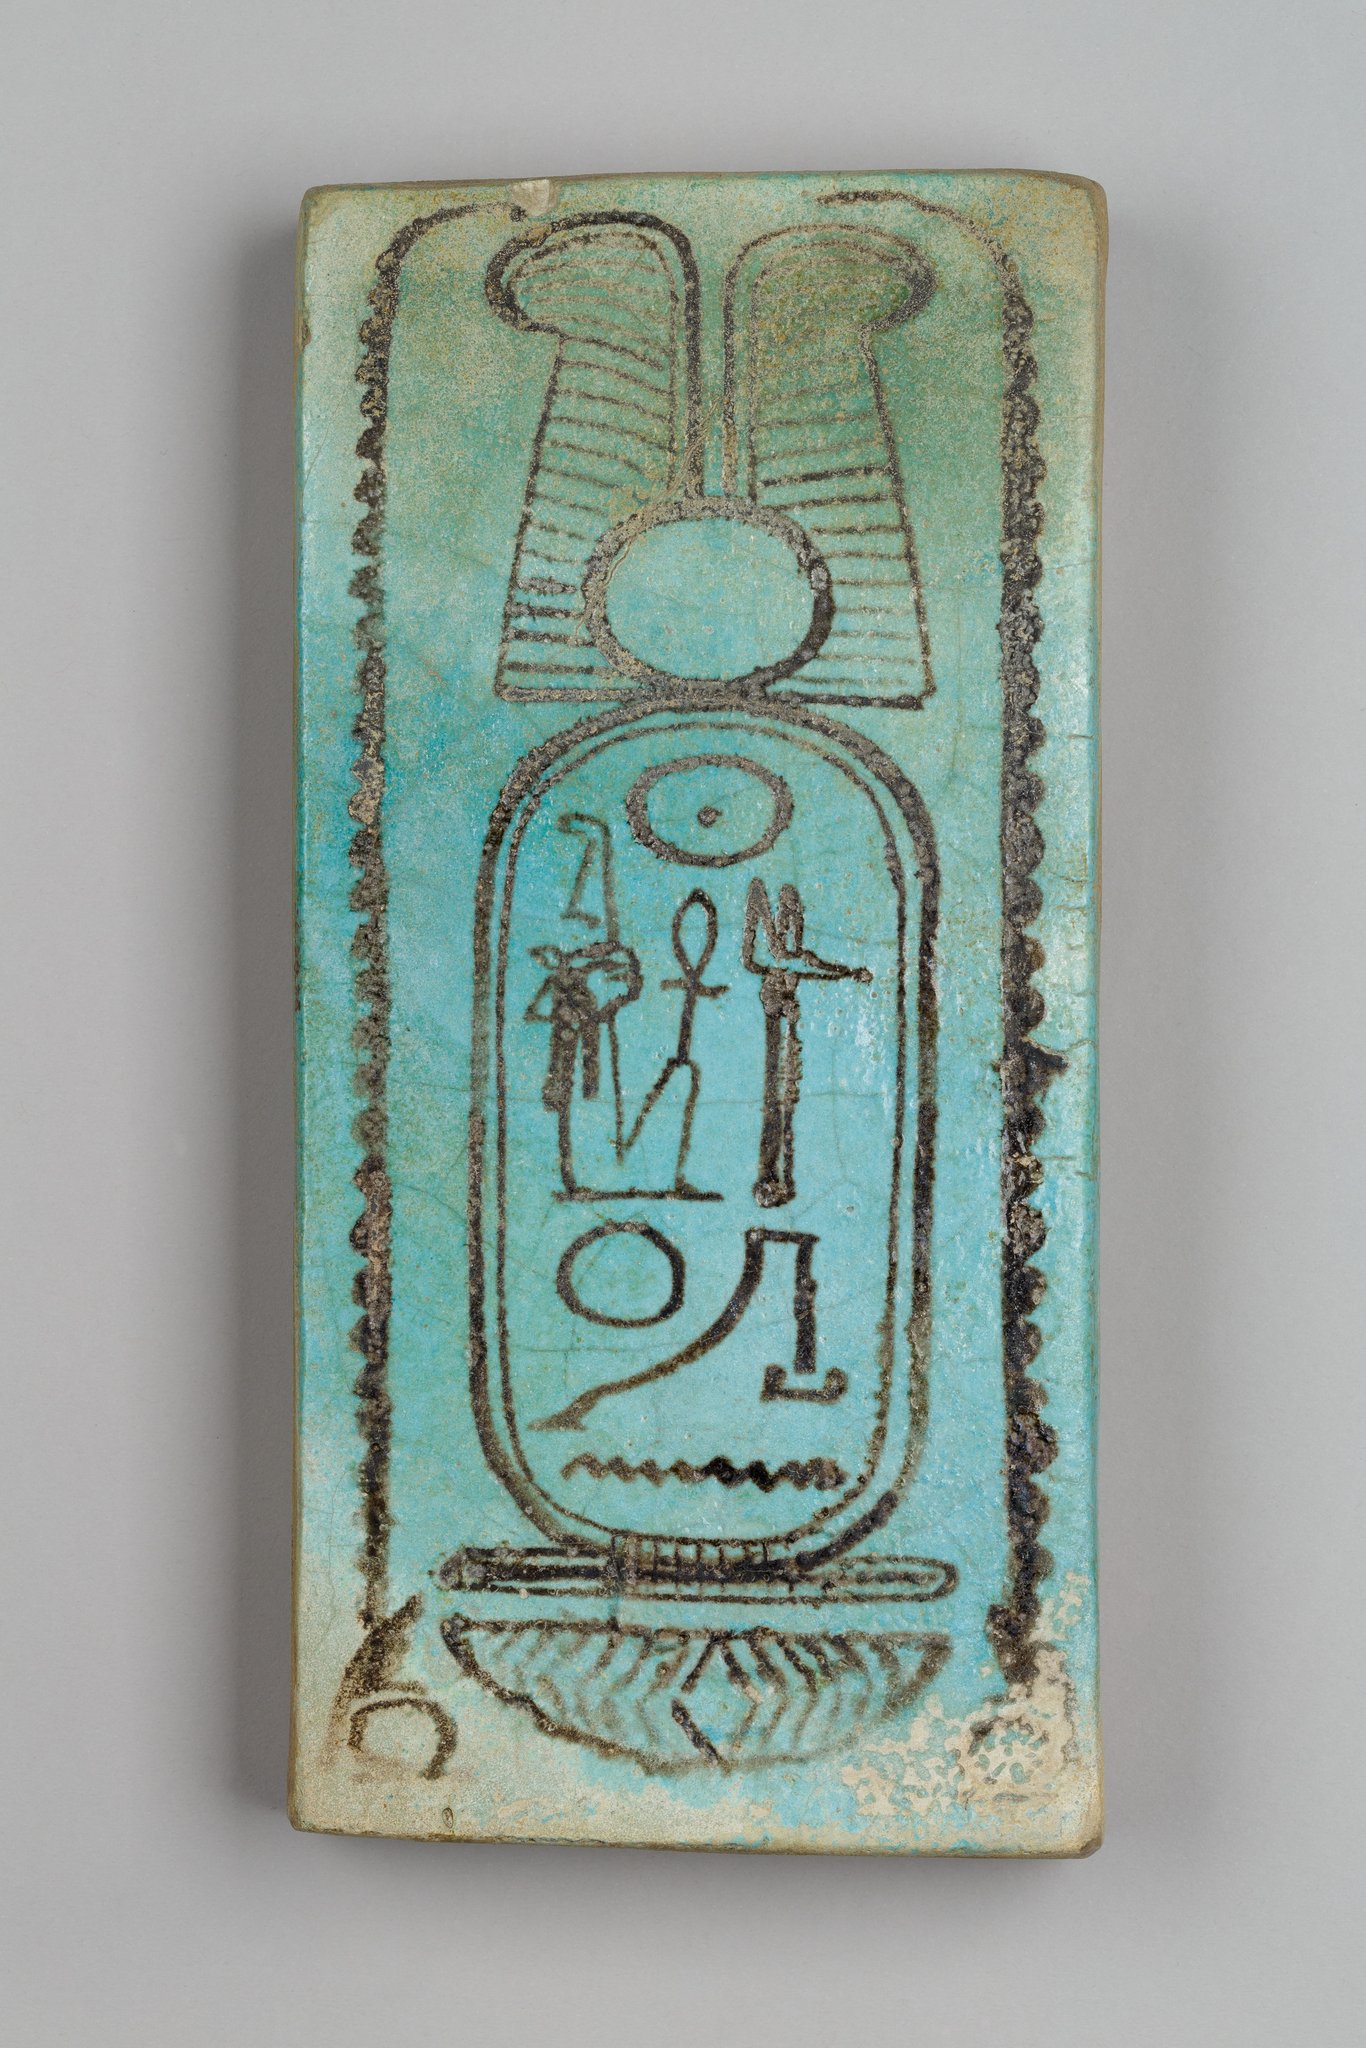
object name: tablet, foundation deposit, brick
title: Foundation deposit brick with name of Ramesses II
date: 1279-1213 BCE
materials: faience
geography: egypt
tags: hieroglyphs